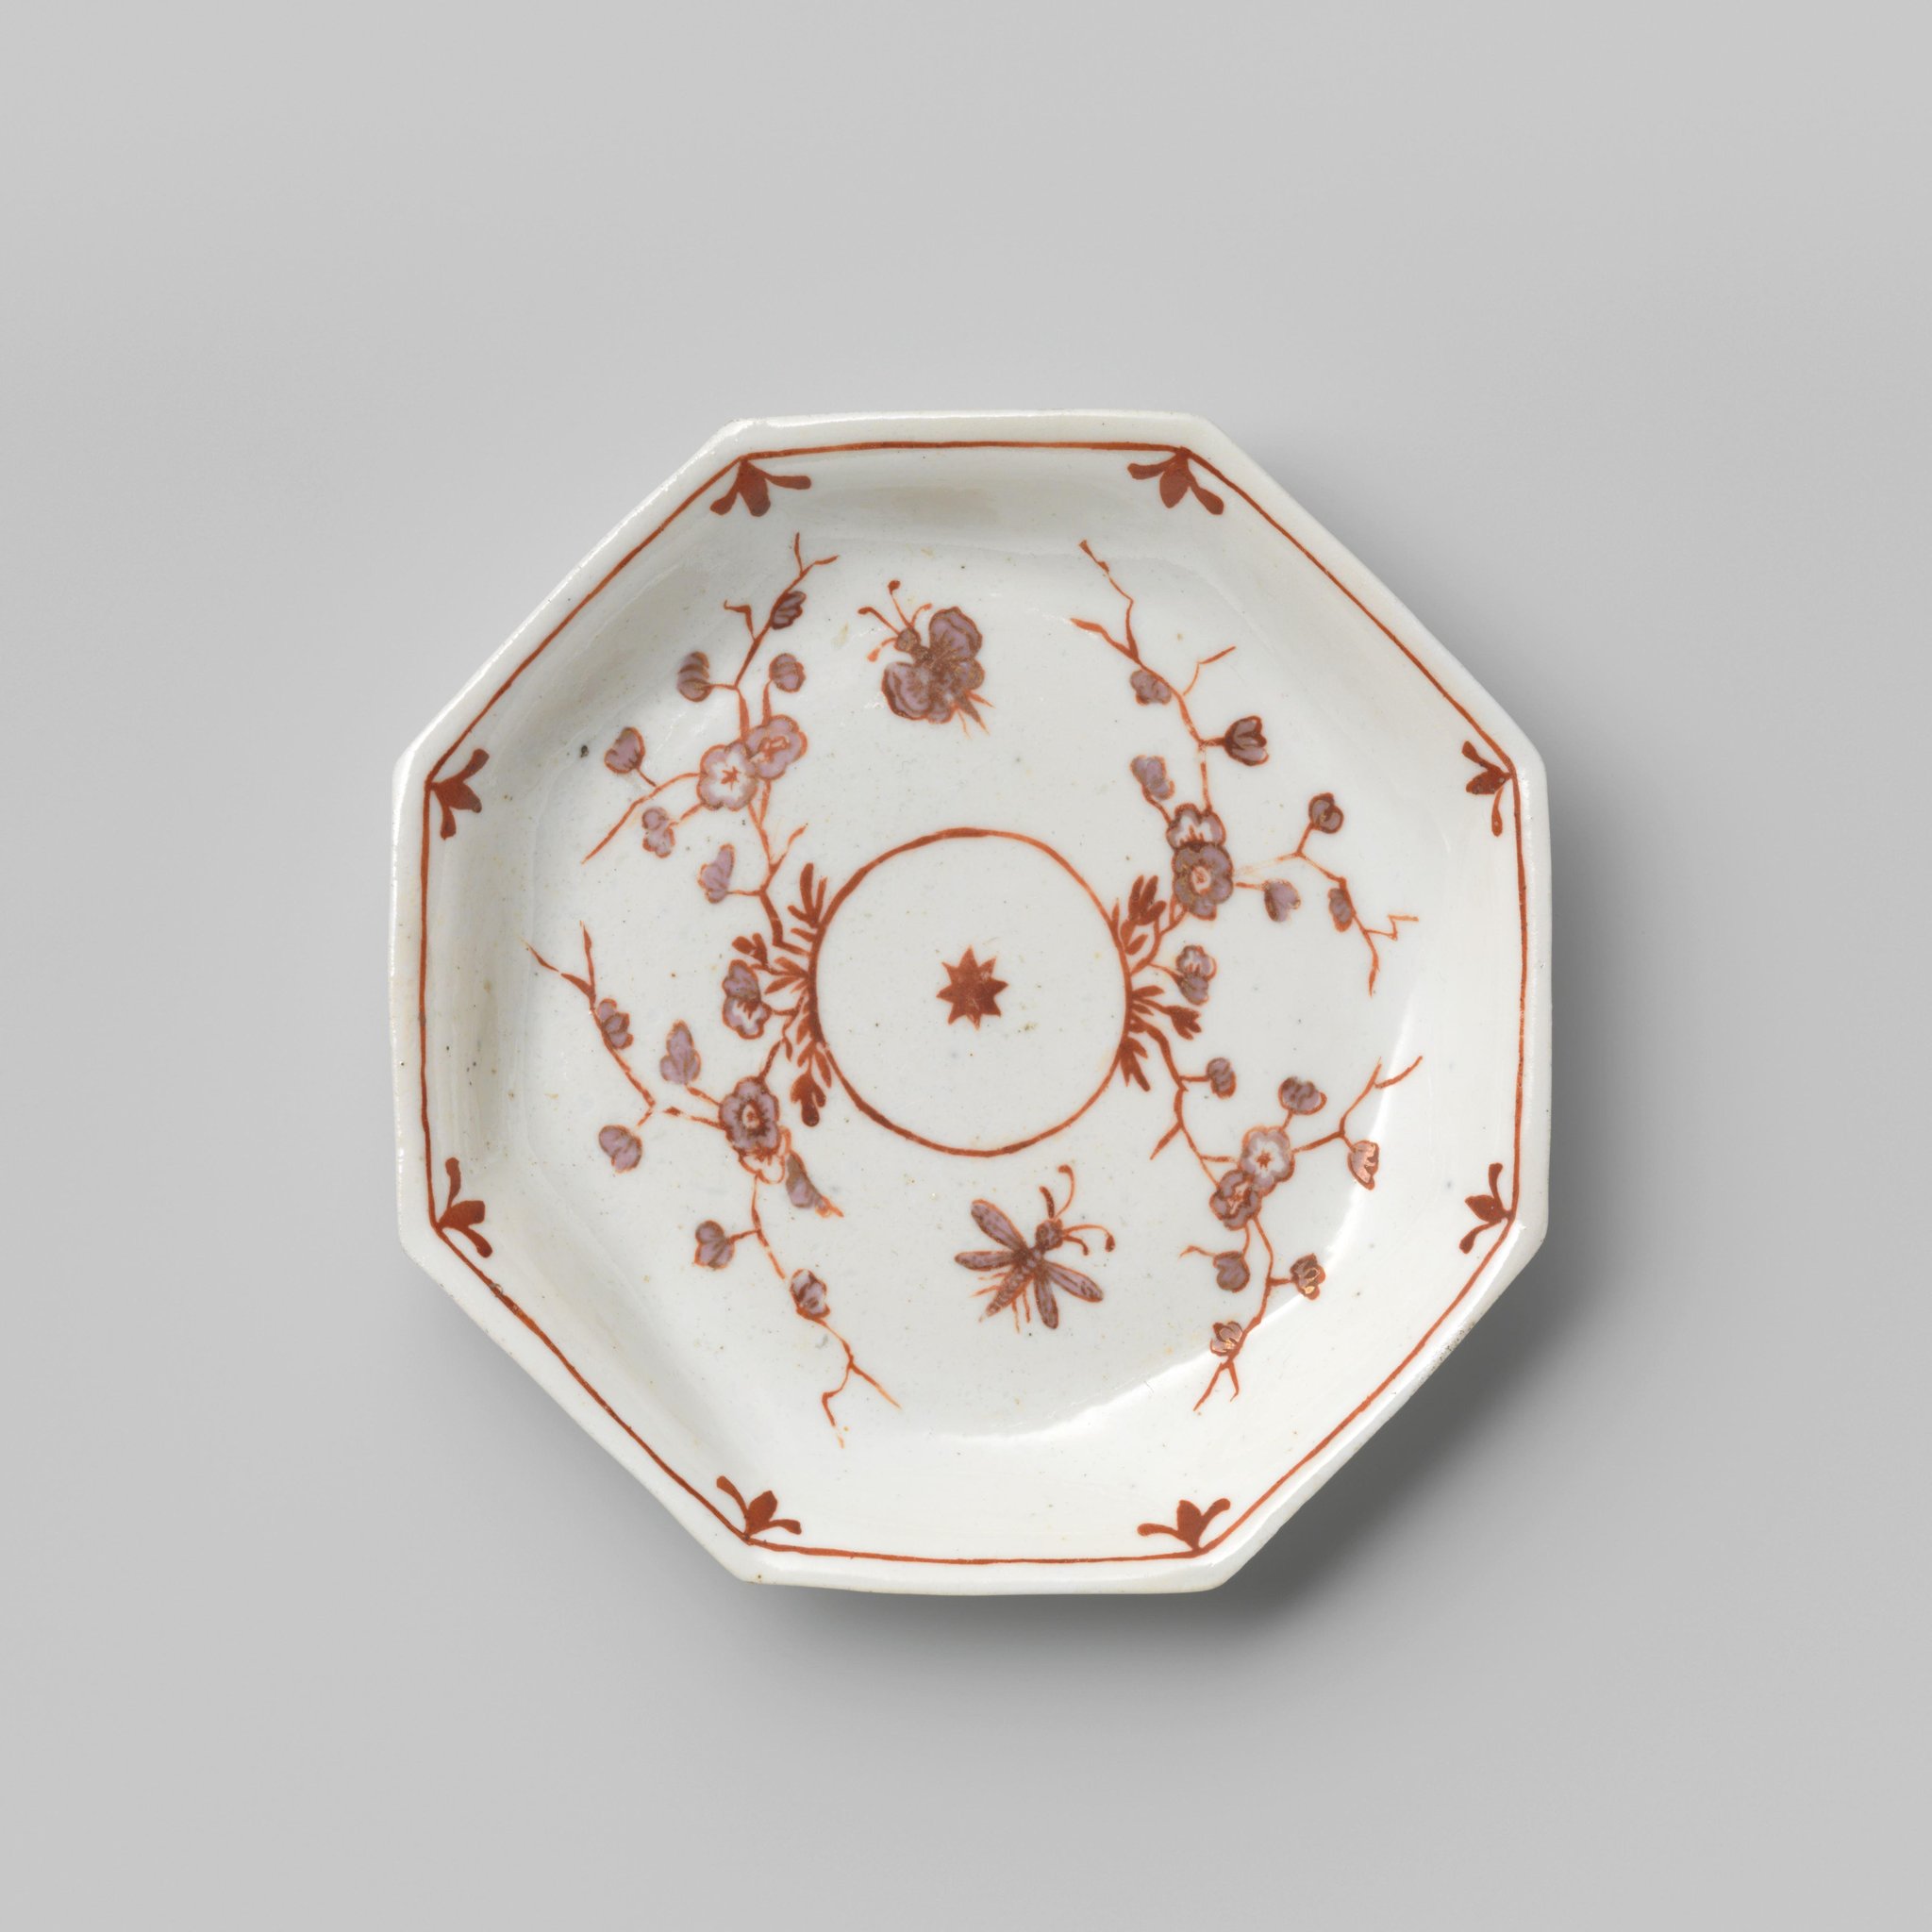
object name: platter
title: Saucer with flowering plants an insects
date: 1720-1727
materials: glaze, gold, paint, porcelain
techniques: firing, forming, gilding, vitrification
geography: venice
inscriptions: mark: ‘VEN:A/ A’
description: Achthoekige schotel van porselein, beschilderd op het glazuur in rood en goud. Op het plat een ster in een medaillon. Op dit medaillon twee bloeiende planten (prunus), waartussen een insect. Een band met bladmotieven op de binnenrand. Gemerkt op de onderzijde met VEN:A en tweemaal A.